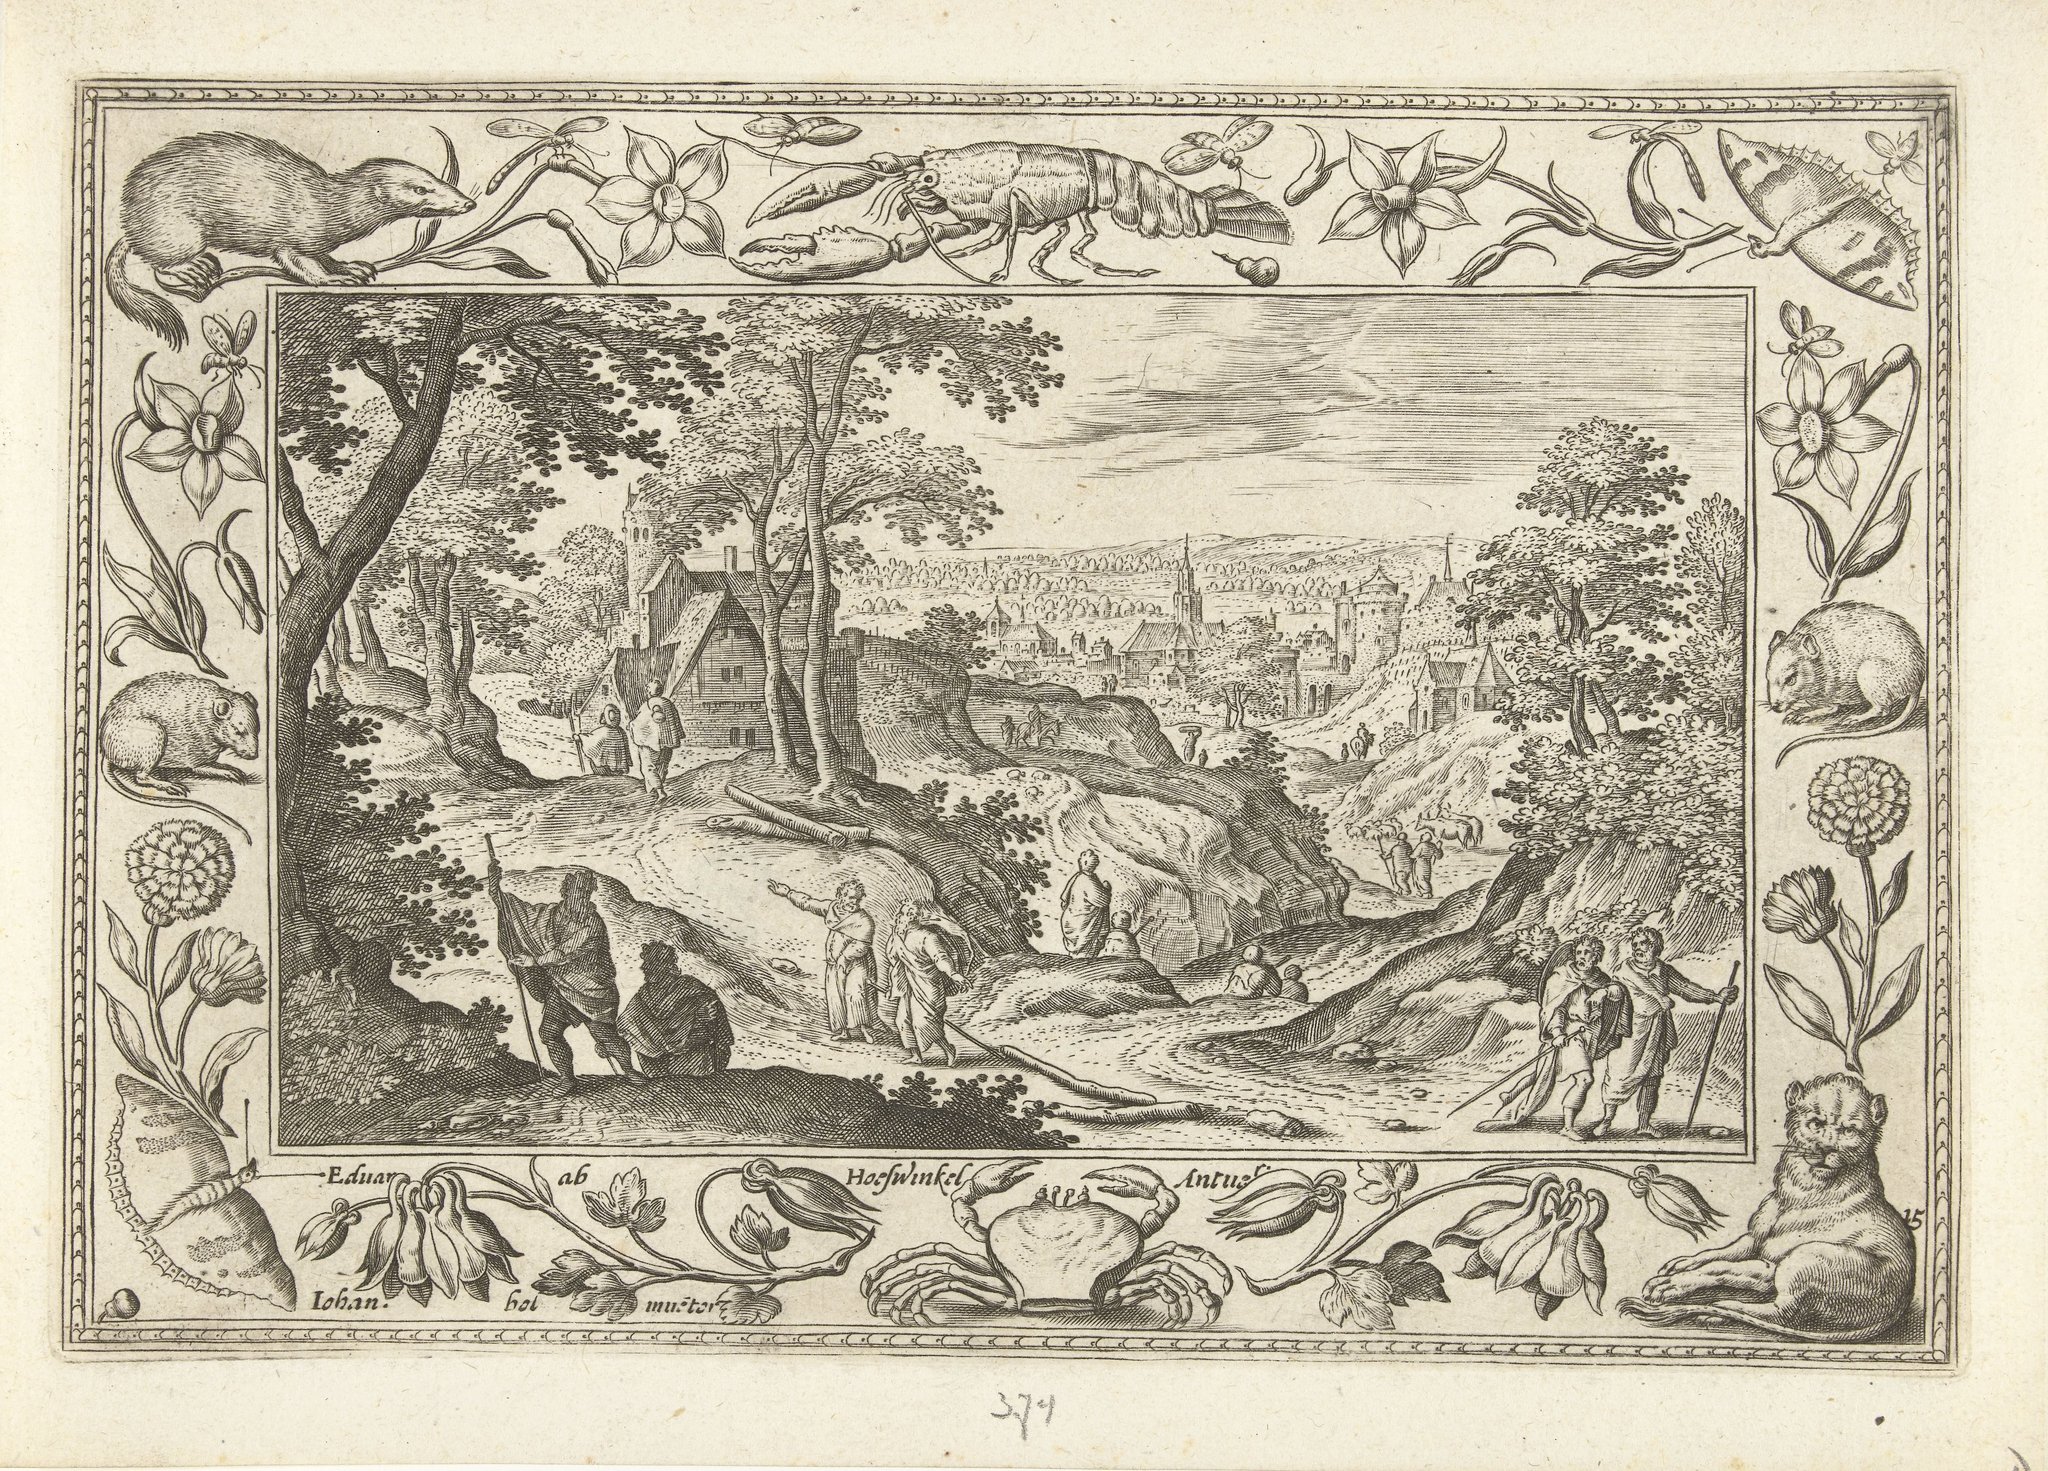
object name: print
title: Uitzending van de apostelen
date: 1582-1586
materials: paper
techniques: engraving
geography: antwerp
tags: christ sends apostles out in pairs (matthew 10:1-16; mark 6:7-11; luke 9:1-5), rodents: rat (+ ornamental variants of animals), insects: butterfly (+ ornamental variants of animals), crustaceans: lobster (+ ornamental variants of animals), public road, flowers ~ ornament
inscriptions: collector's mark: Lugt 2228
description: Landschap nmet een weg. Op verschillende plekken in het landschap apostelen, die in paren op reis zijn om de booschap van Christus te verkondigen. De prent heeft een ornamentele lijst met bloemen, vlinders en dieren. Hij maakt deel uit van een vierentwintigdelige serie van landschappen met Bijbelse, mythologische scènes en jachttaferelen.